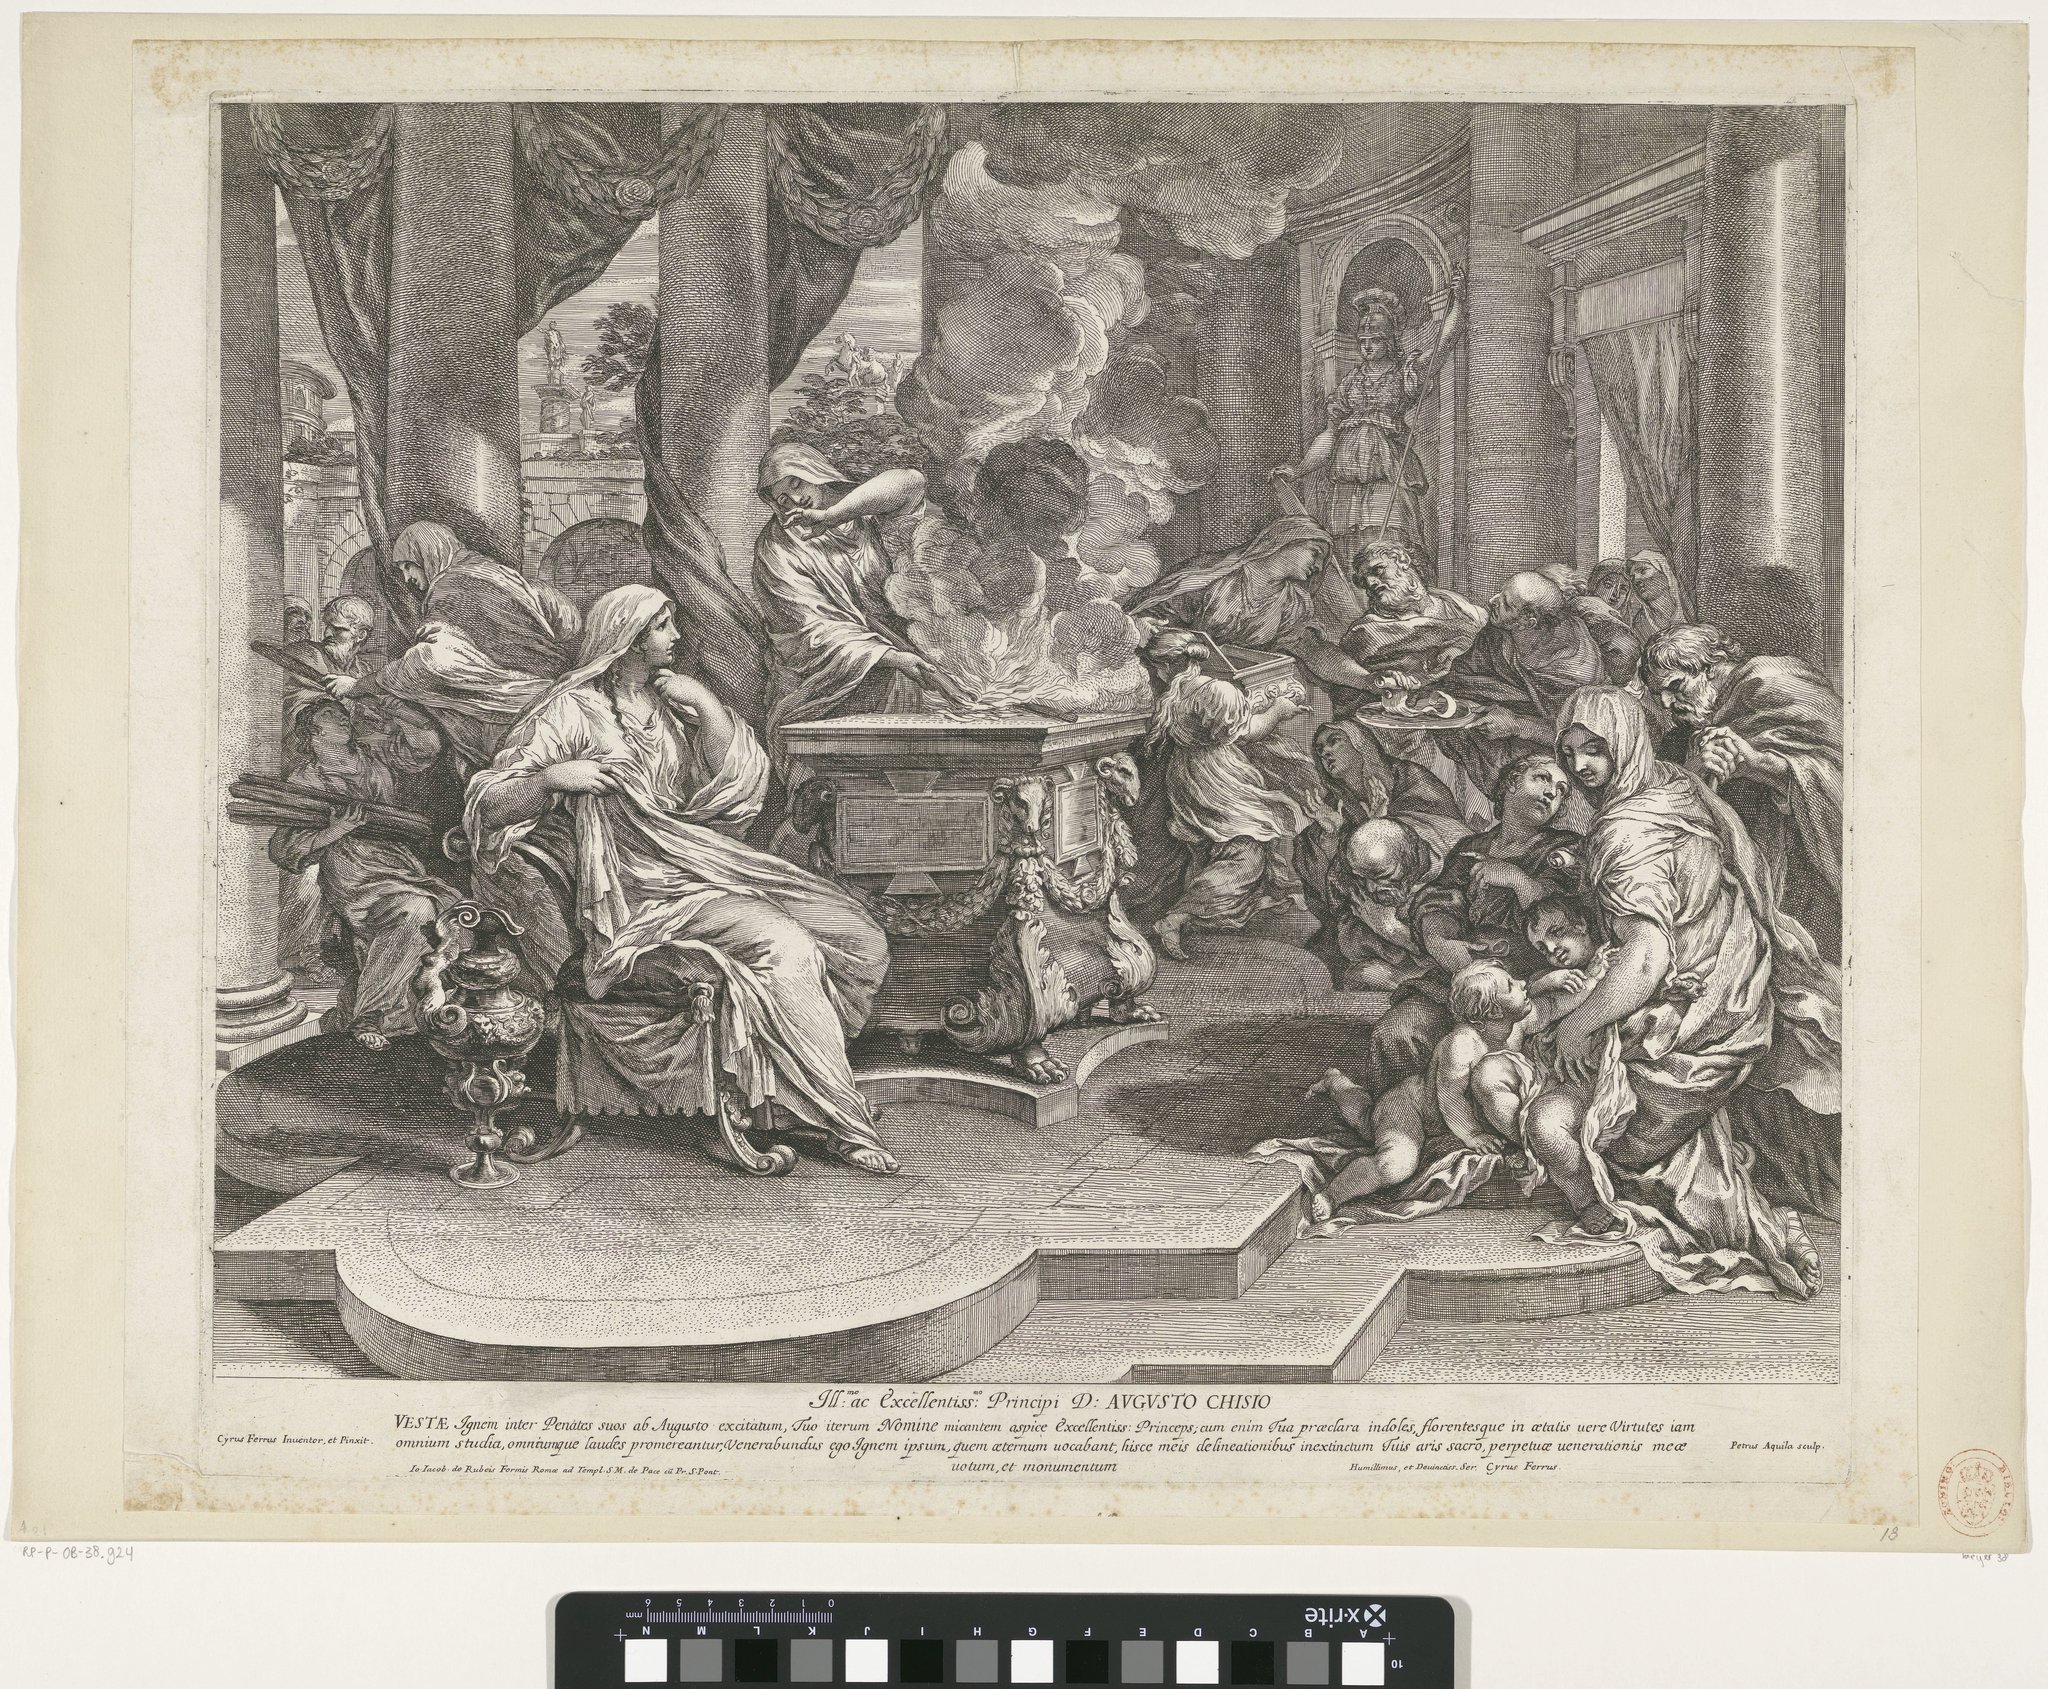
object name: print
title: Vestaalse Maagden offeren voor het heil van Augustus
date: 1660-1692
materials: paper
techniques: etching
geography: italy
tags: vestal virgin(s), sacrifice ~ roman religion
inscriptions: collector's mark: Lugt 240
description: De Vestaalse Maagden brengen een brandoffer voor het heil van Augustus op een altaar in een tempel. Een groep mensen klijkt toe. Tekst in ondermarge.